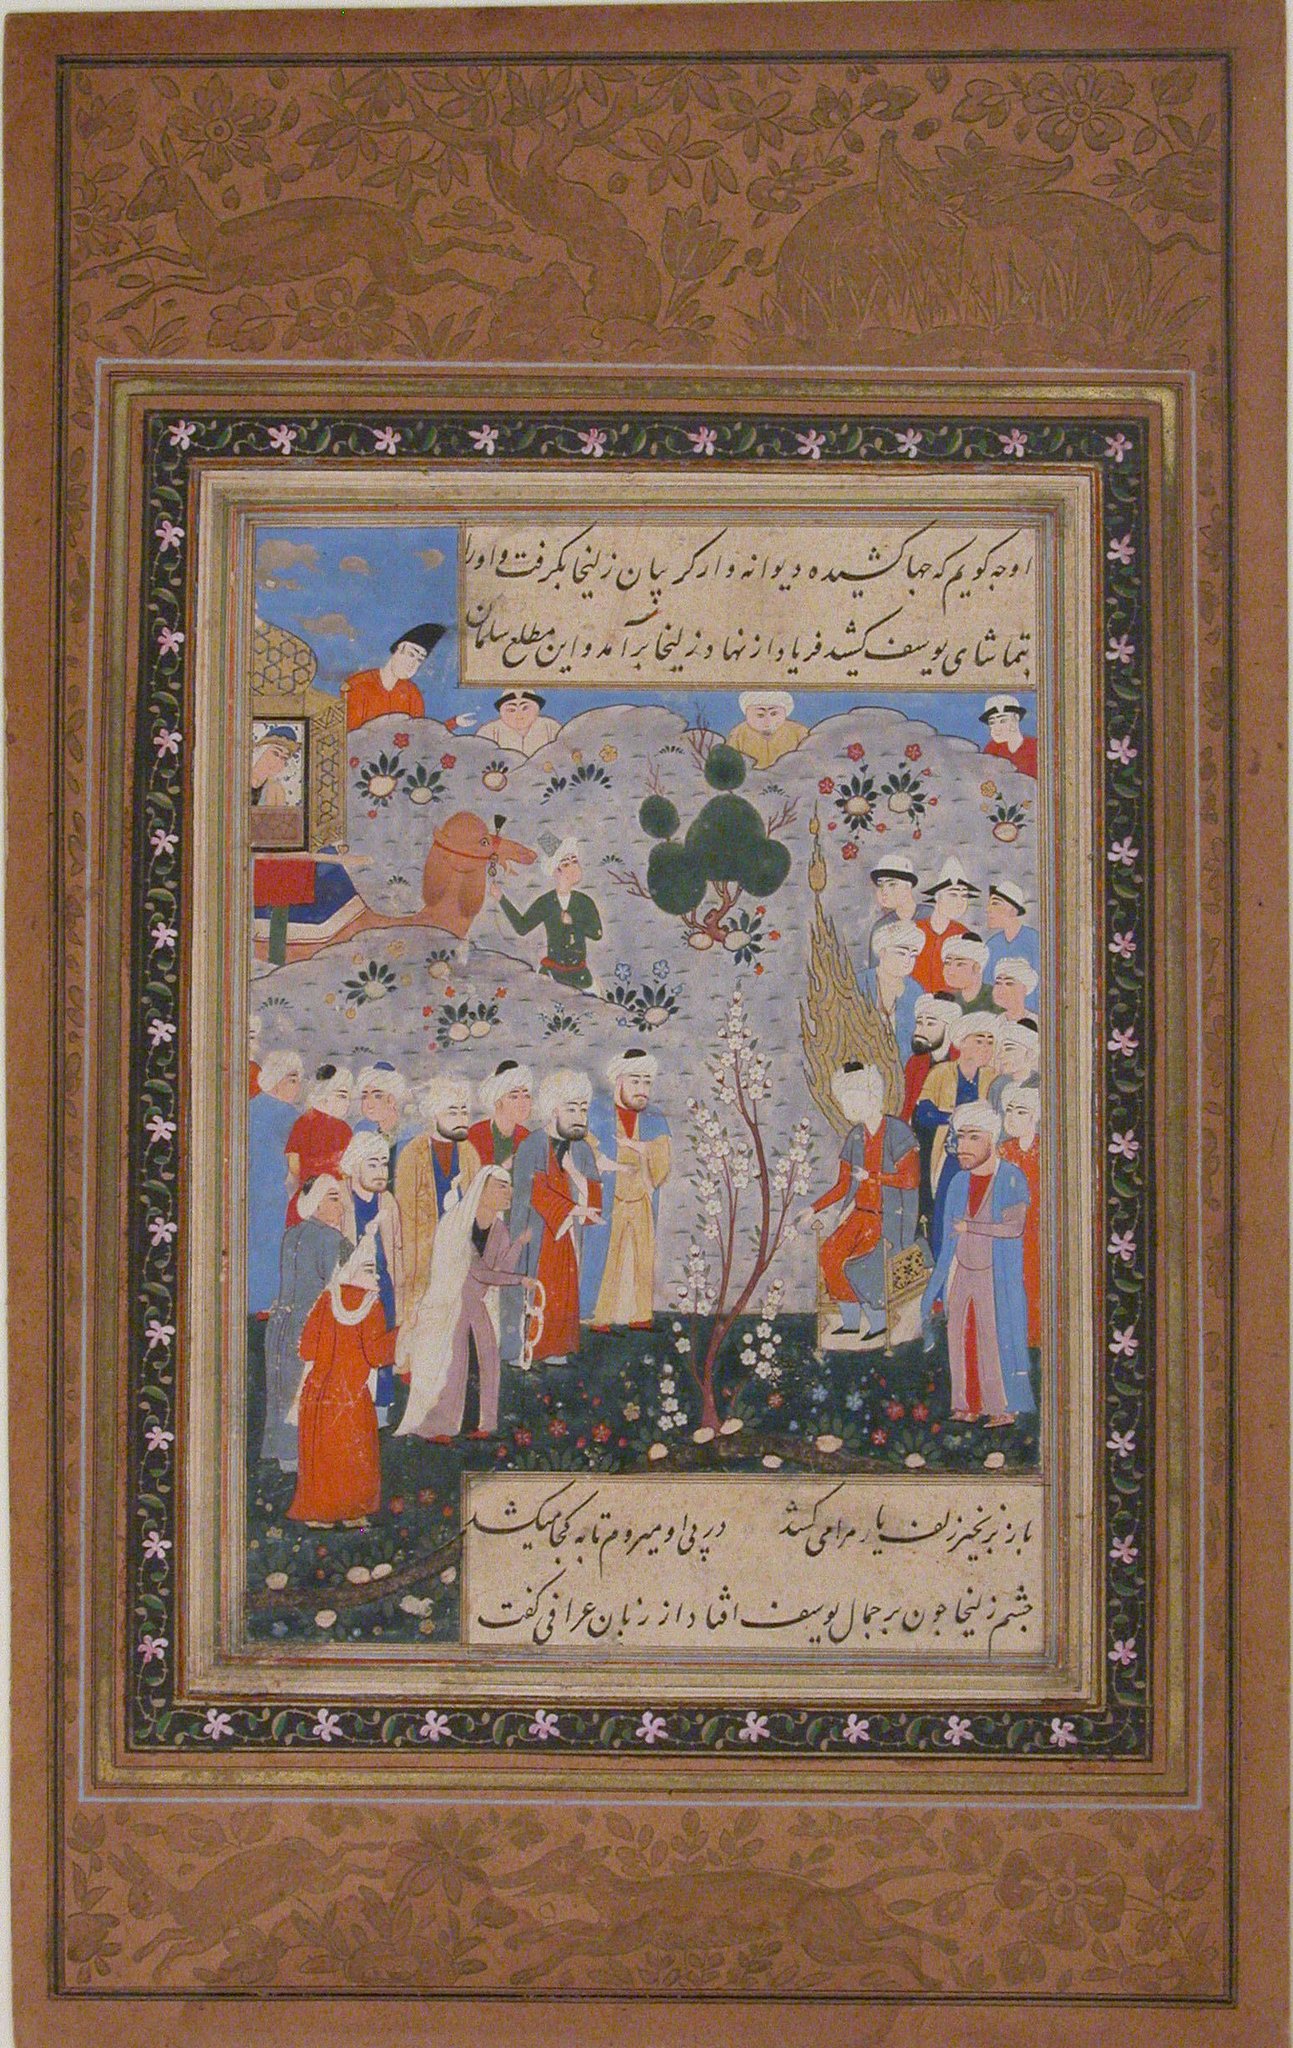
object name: folio from an illustrated manuscript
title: "Zulaykha Bidding for Yusuf in the Slave Market in Egypt", Folio from Yusuf and Zulaykha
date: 1551-1600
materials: gold, ink, paper, watercolor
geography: iran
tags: men,camels